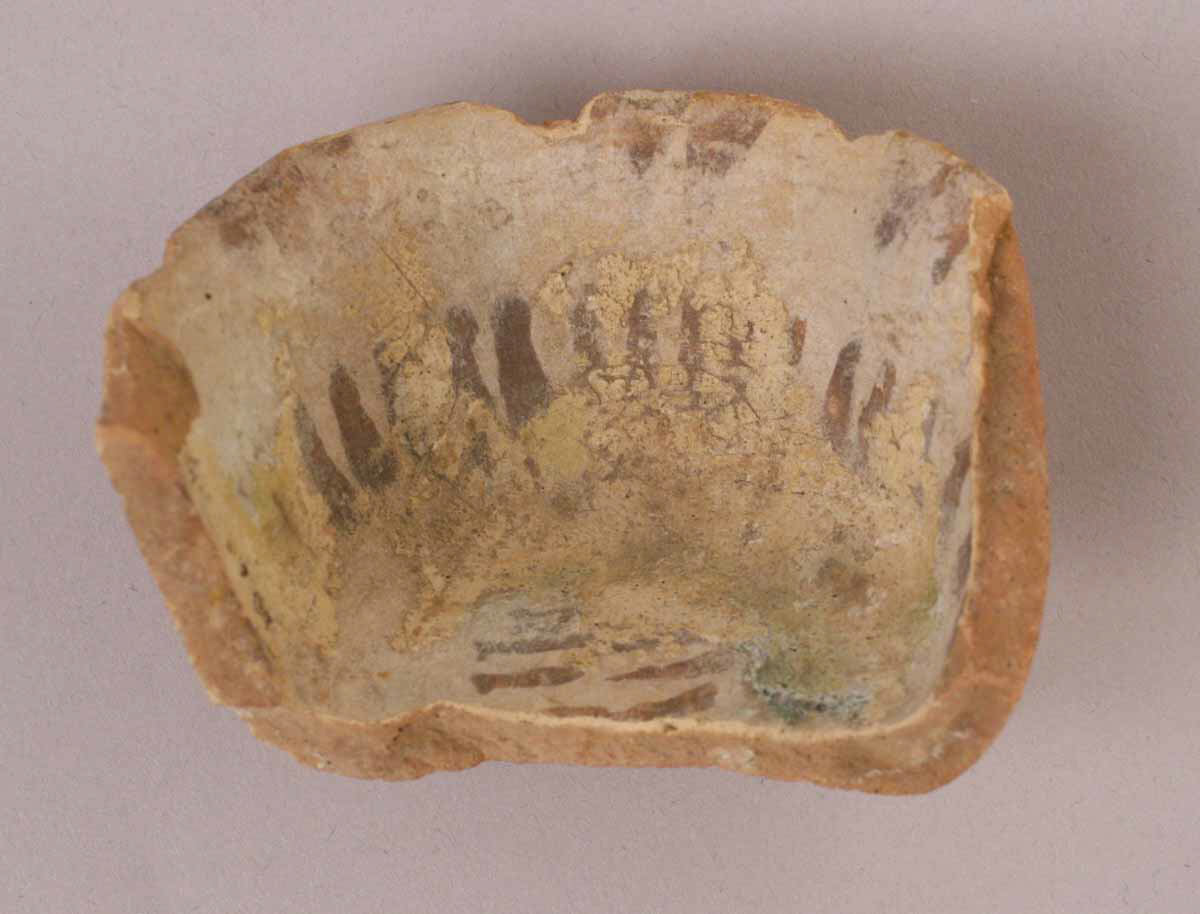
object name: fragment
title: Ceramic Fragment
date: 701-900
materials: earthenware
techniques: glazing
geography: iraq